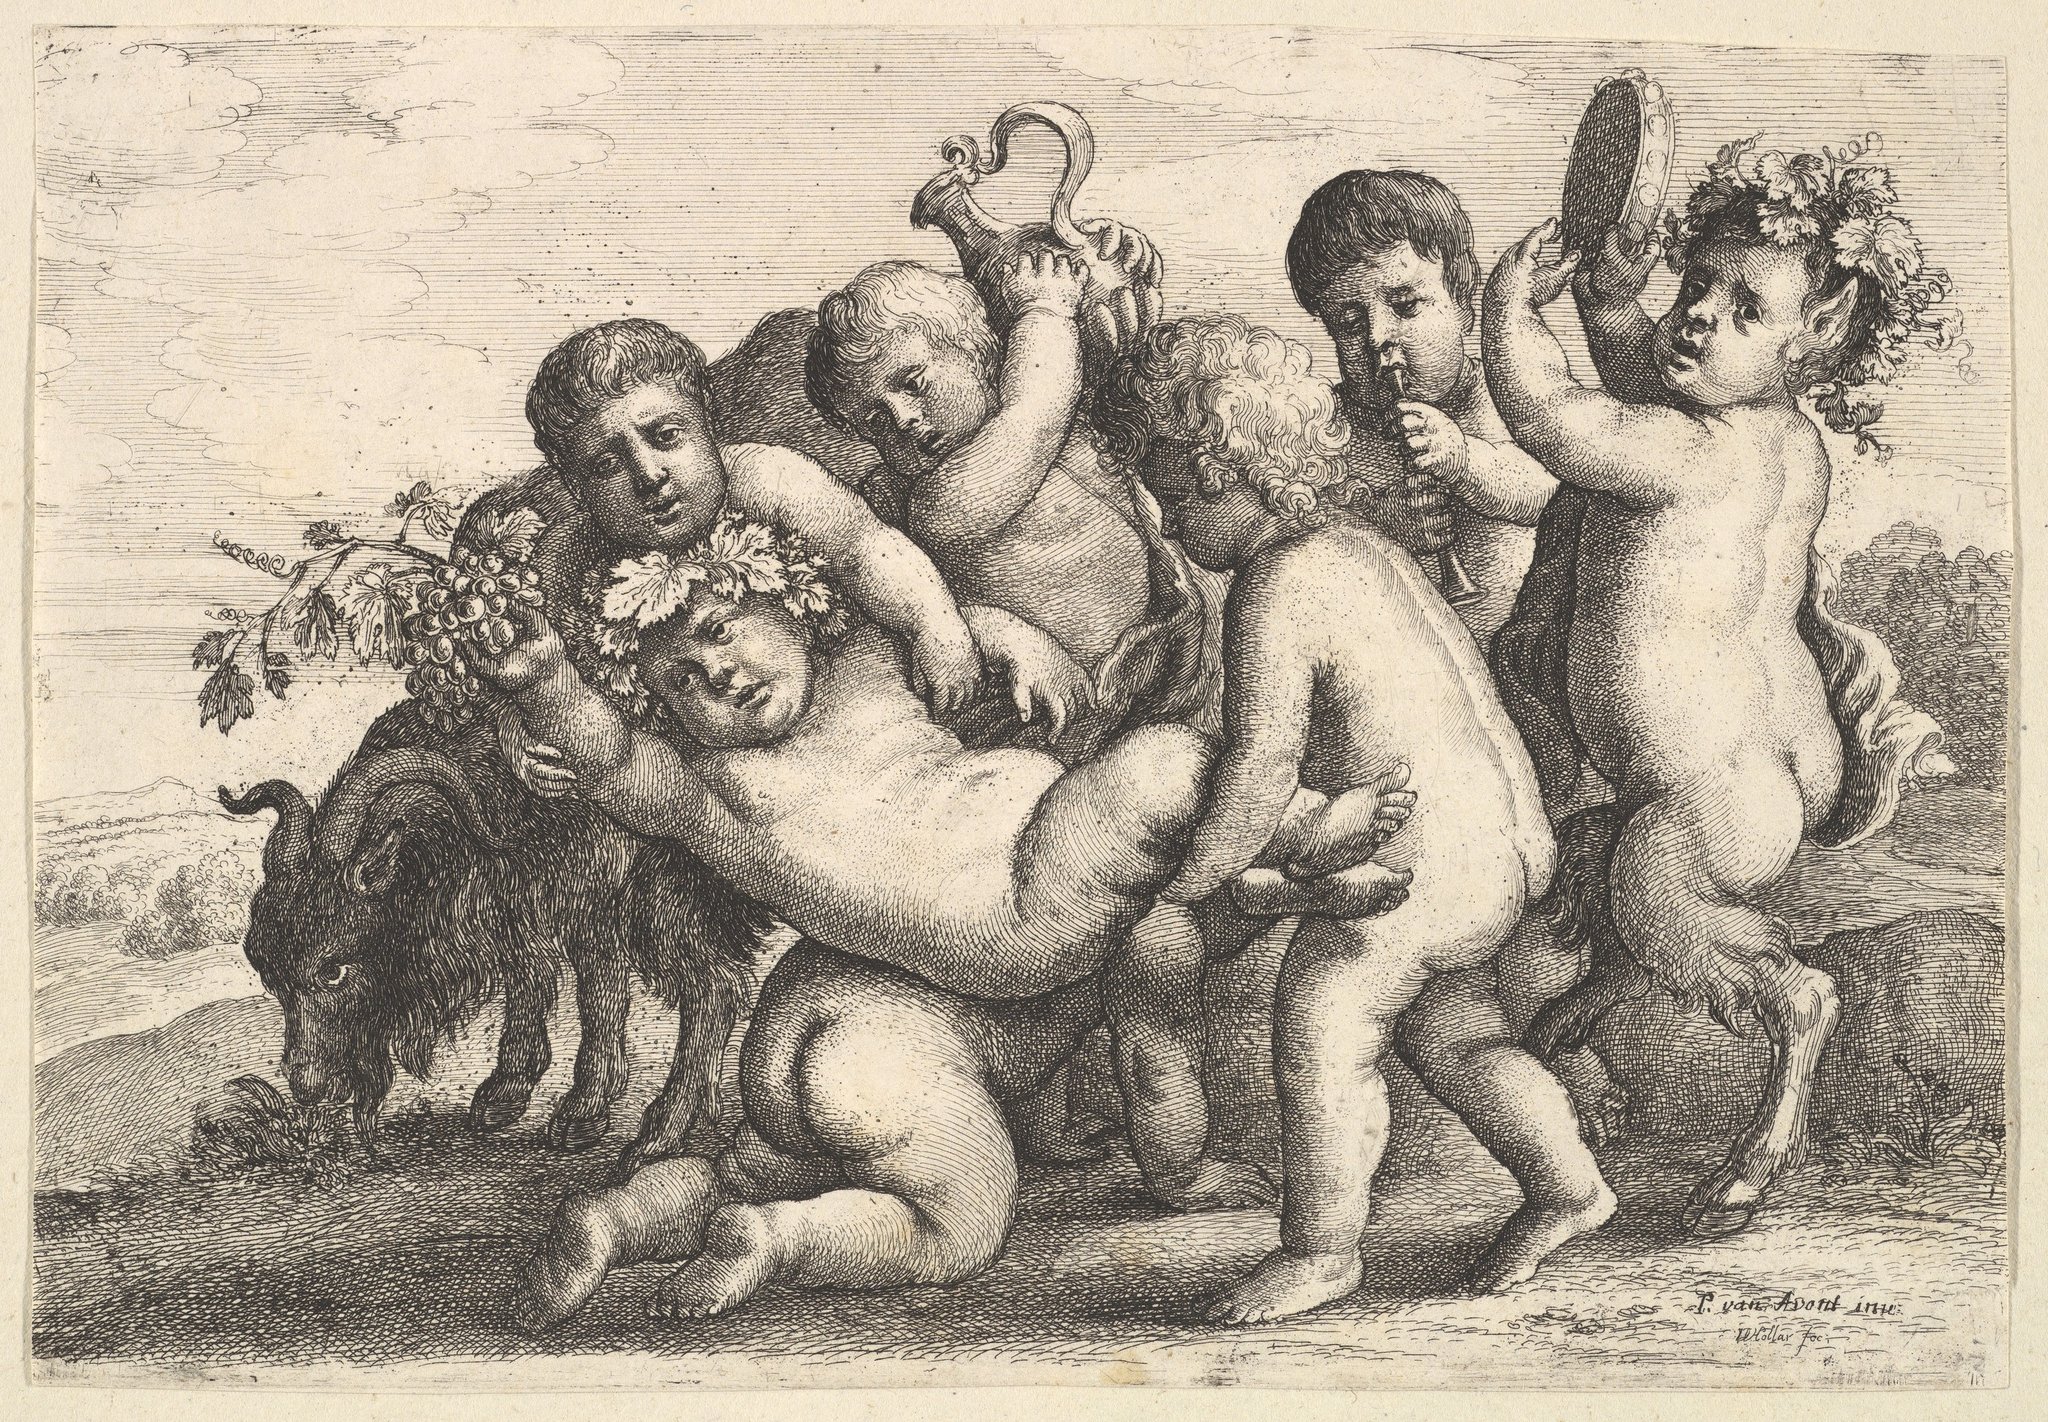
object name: print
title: Five boys, two satyrs and a goat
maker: wenceslaus hollar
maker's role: artist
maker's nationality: bohemian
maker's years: 1607-1677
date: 1647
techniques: etching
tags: boys,satyrs,goats